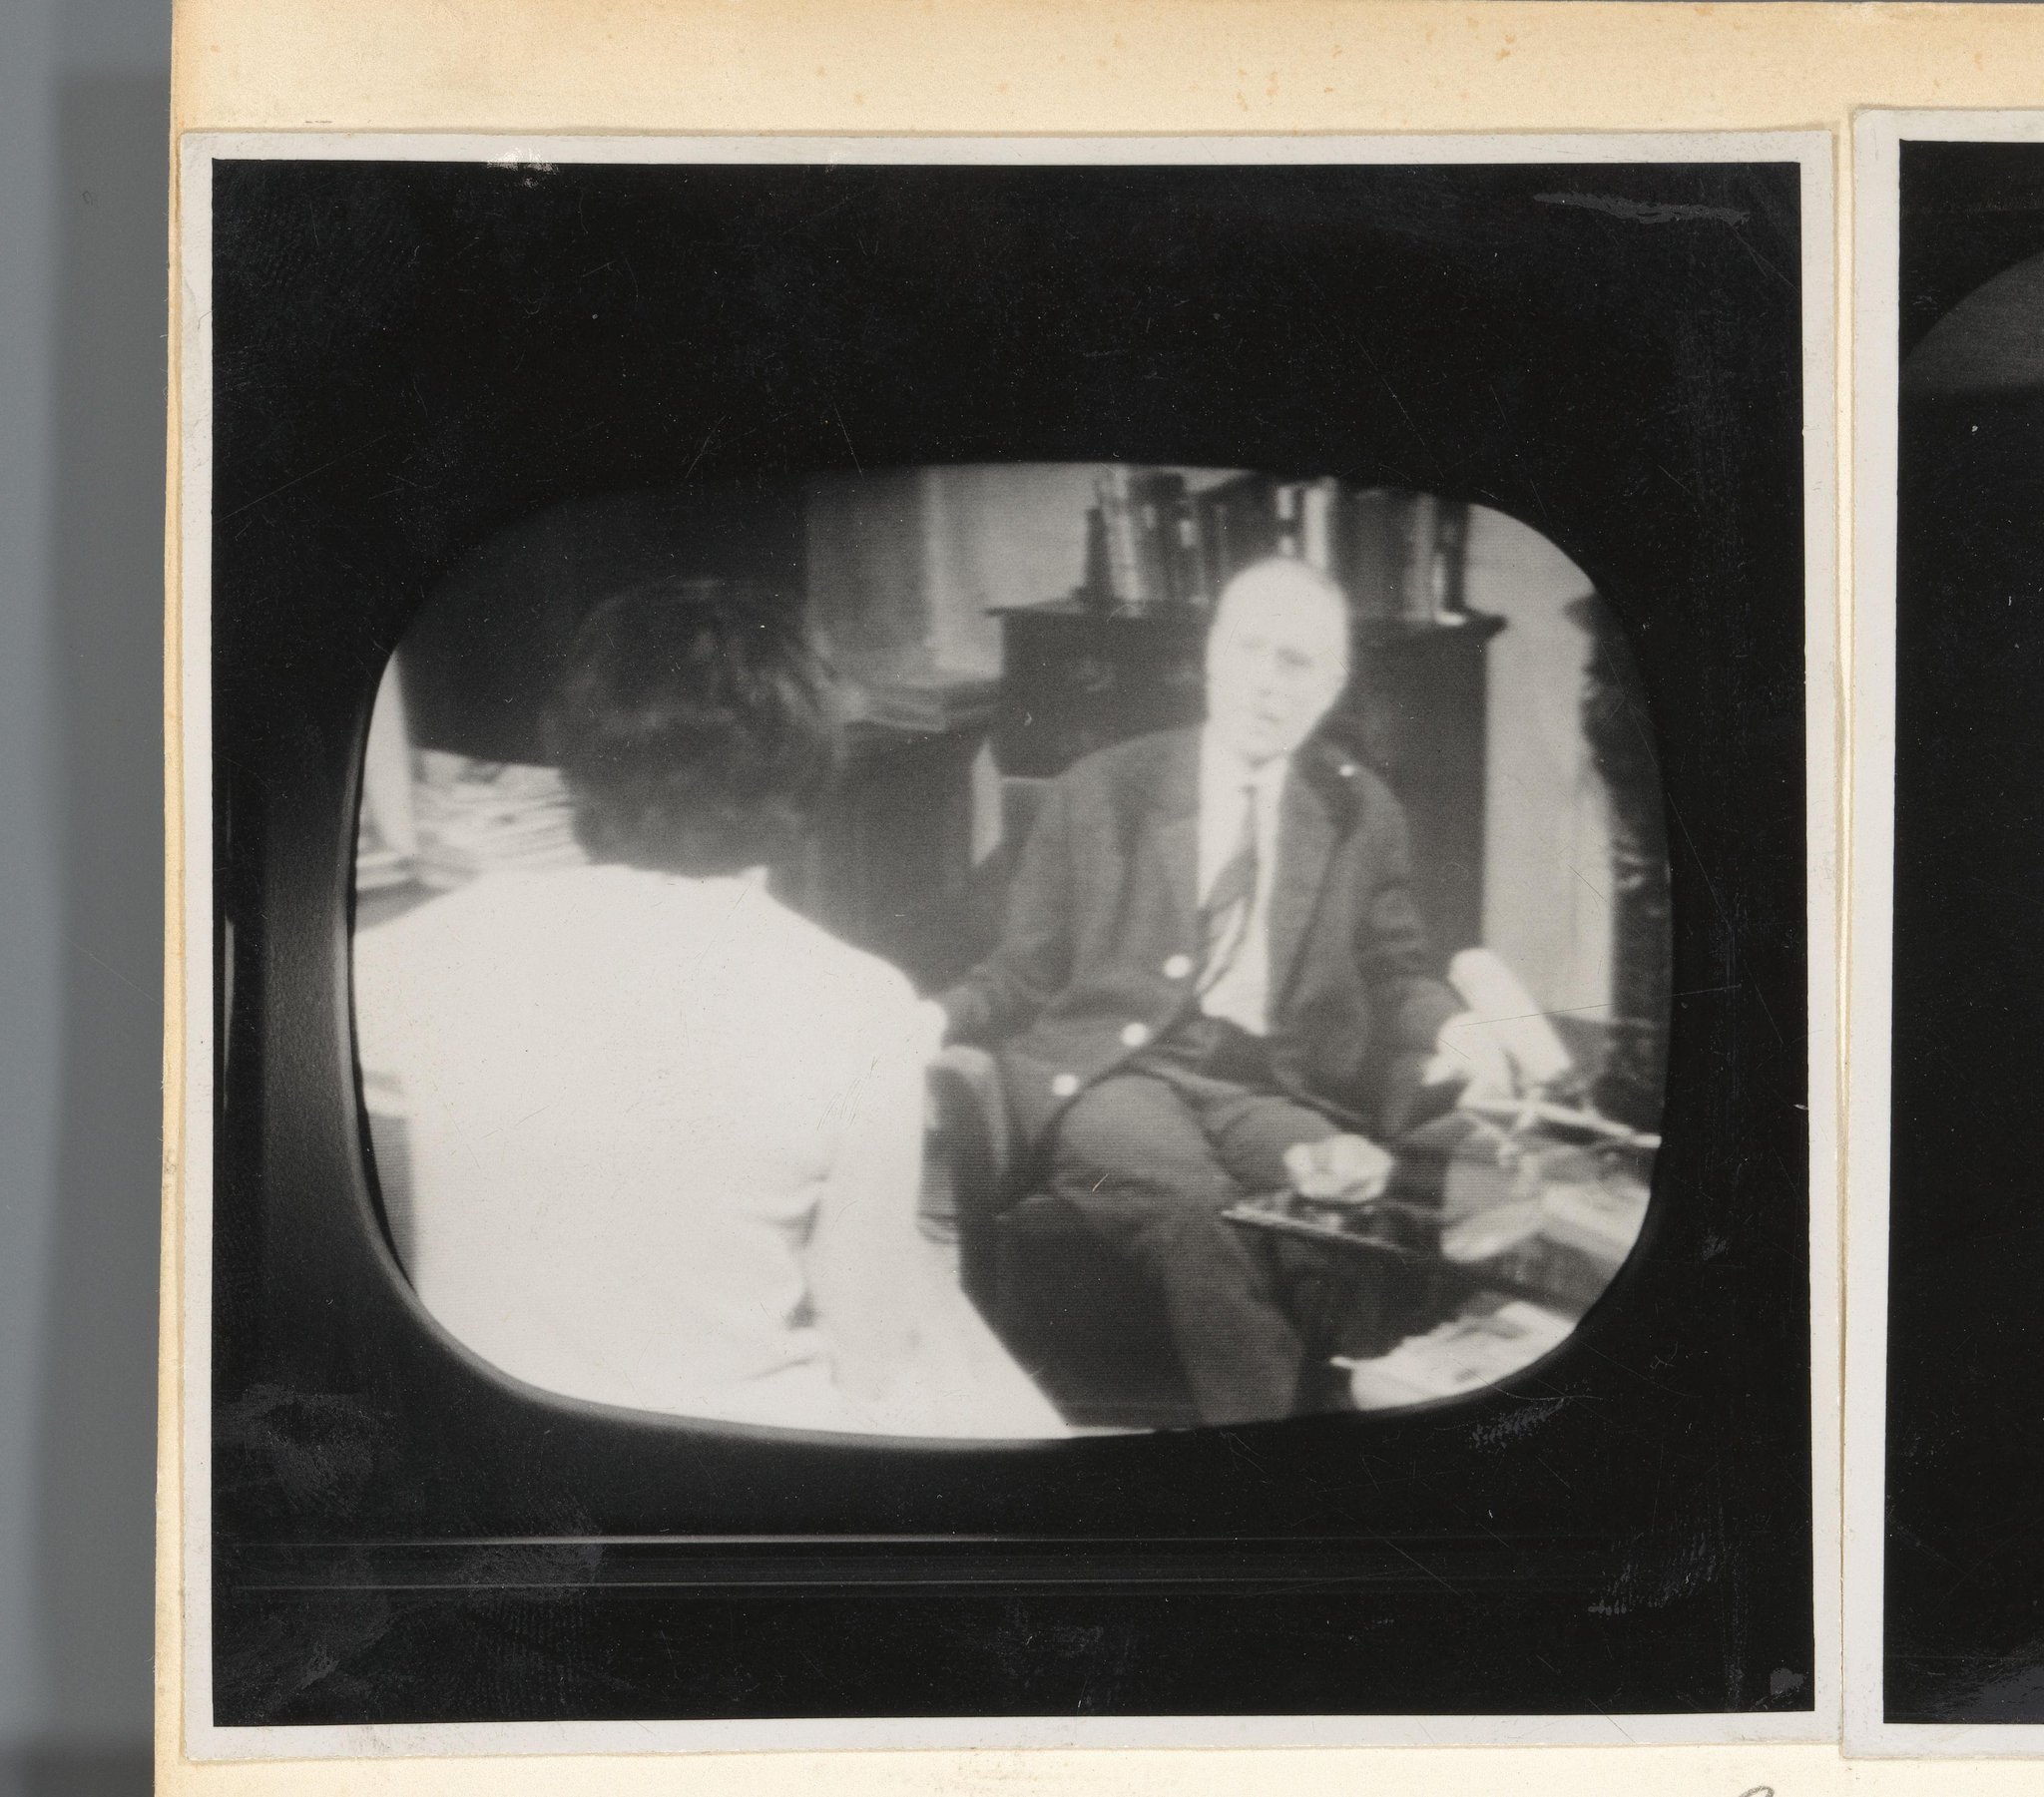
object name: photograph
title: Foto van televisiebeeldscherm, waarschijnlijk tijdens de uitzending van de film 'Carel Willink' door Helène van Zijl, Lies Westenburg en Hans Redeker (1963)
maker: Anonymous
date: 1963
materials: cardboard, paper, photographic support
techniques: gelatin silver print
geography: netherlands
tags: television, television broadcasting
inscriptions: stamp: ‘FOTO E. VAN MOERKERKEN / COPYRIGHT / E. VAN MOERKERKEN / AMSTERDAM / No.’